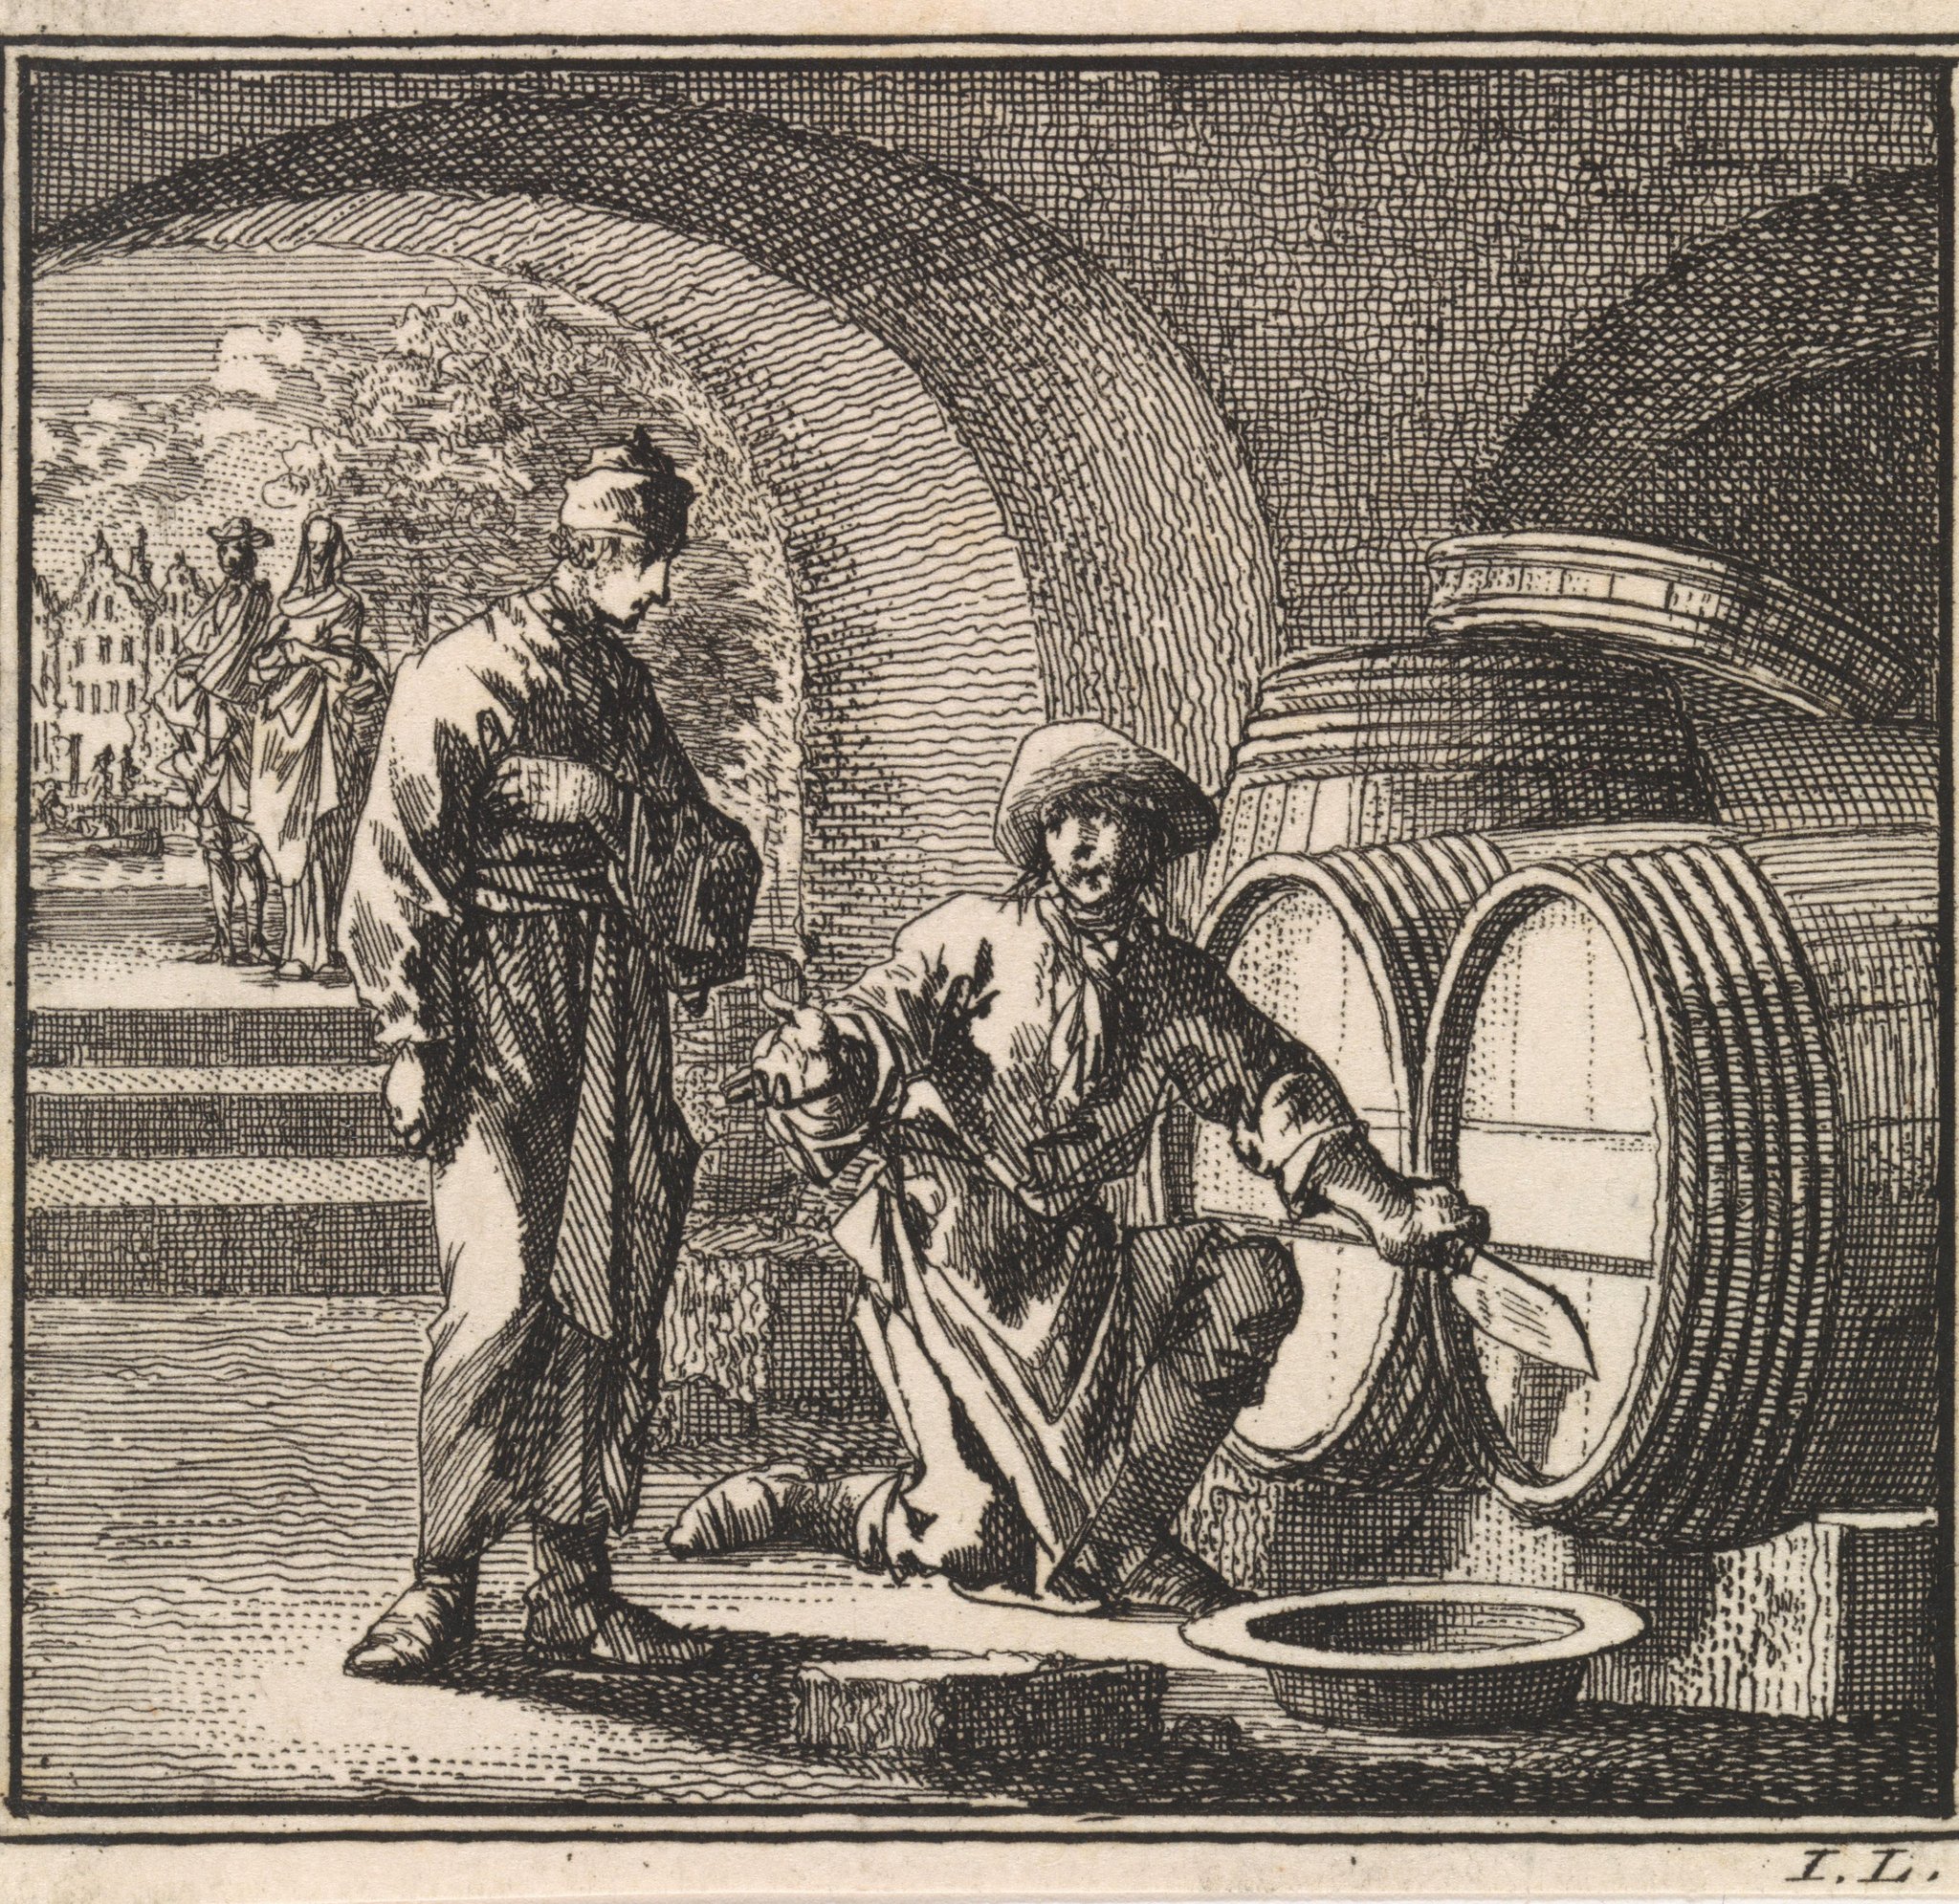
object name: print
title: Twee mannen bij een wijnvat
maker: jan luyken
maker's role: draughtsman, print maker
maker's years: 1649-1712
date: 1711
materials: paper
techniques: etching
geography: amsterdam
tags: wine-cellar, wooden container: barrel, cask, bucket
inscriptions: collector's mark: Lugt 2228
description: Illustratie voor: Luyken, Jan. De Bykorf des Gemoeds. Amsterdam: Pieter Arentsz. II (wed.) en Cornelis van der Sys, 1711, p. 298.